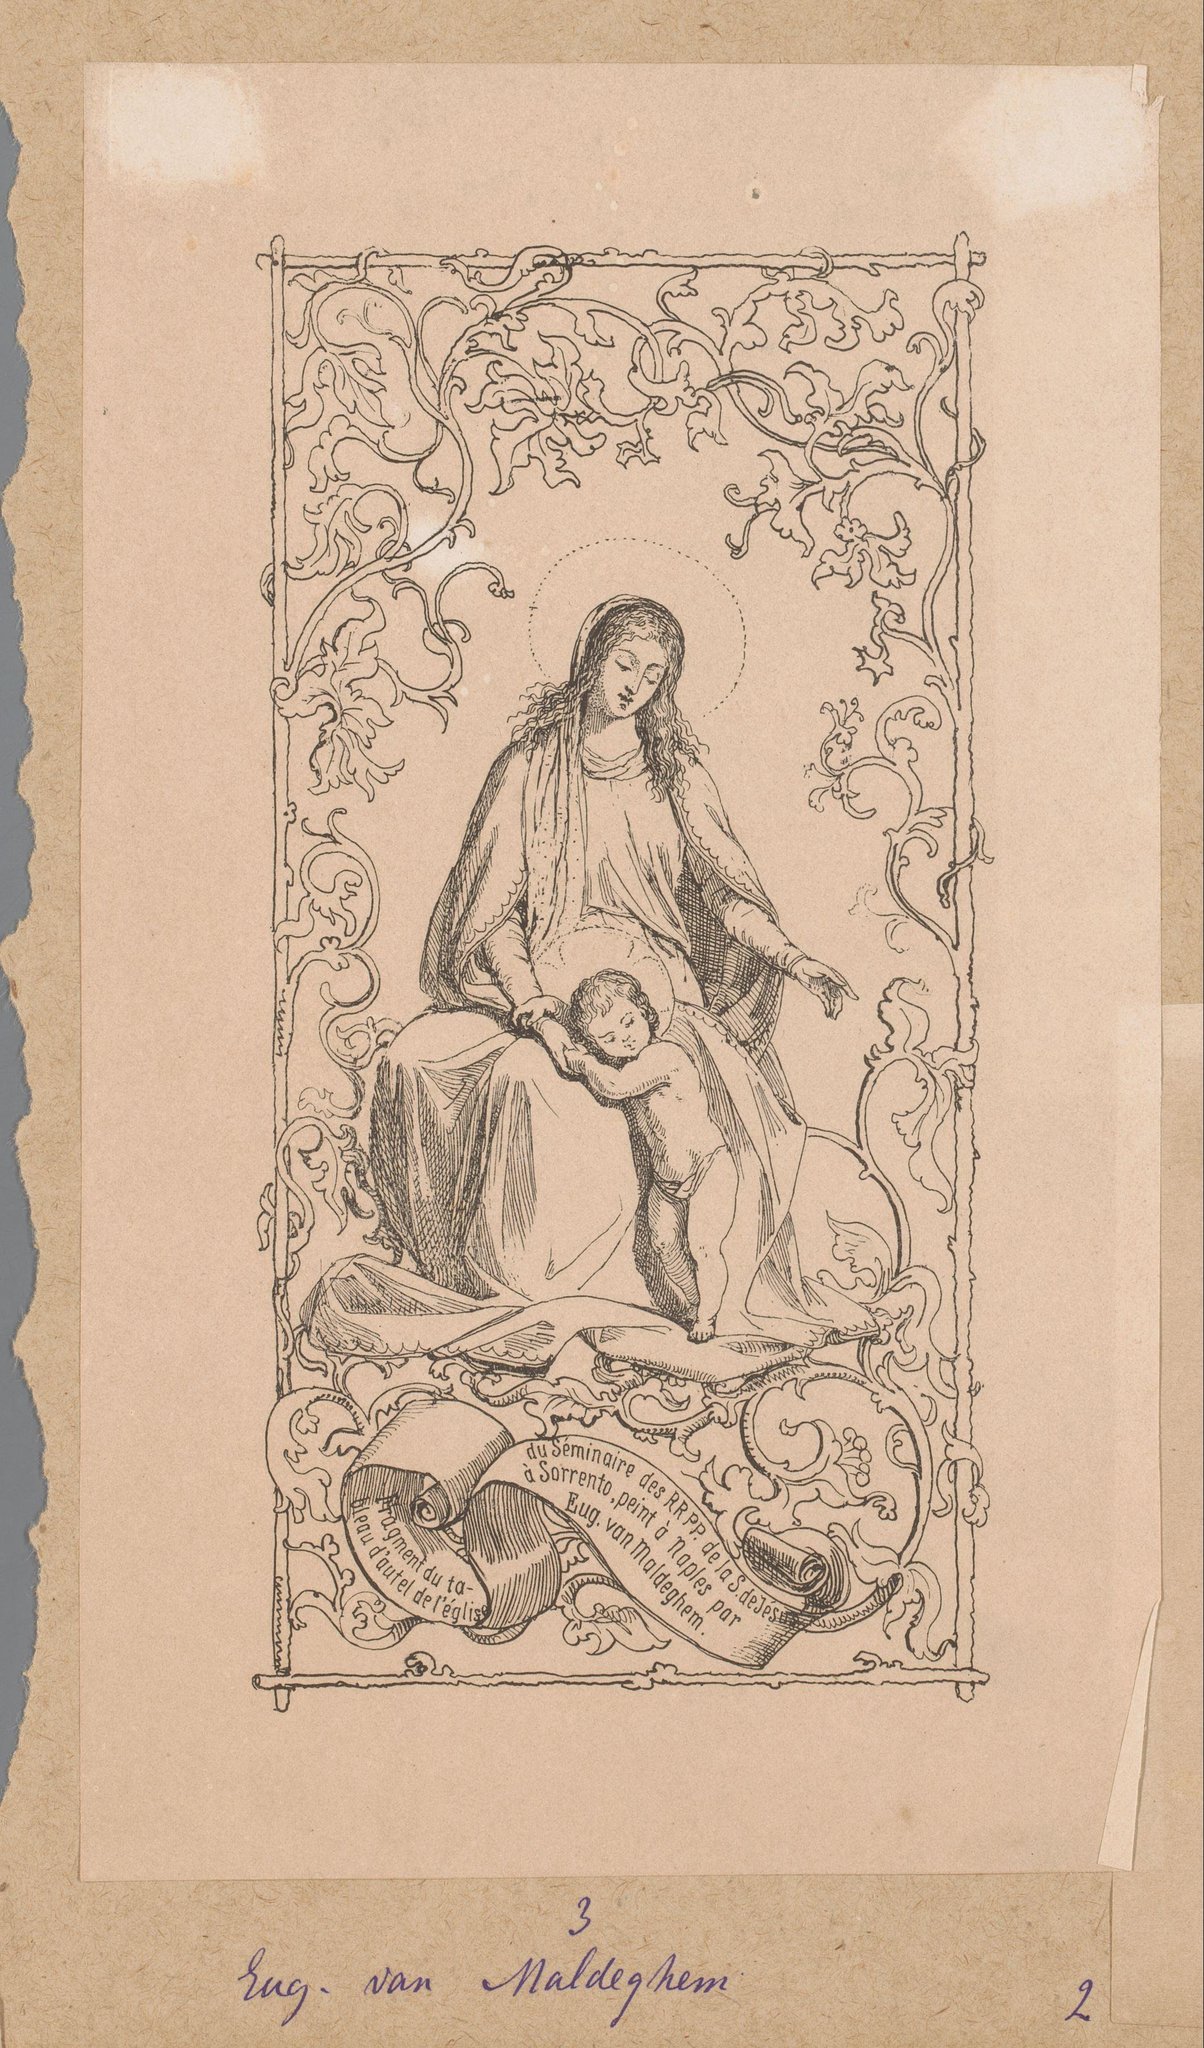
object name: print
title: Fragment du tableau d'autel de l'église (...) Naples par Eug. van Maldeghem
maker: eugène van maldeghem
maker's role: draughtsman, painter, print maker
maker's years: 1813-1867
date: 1823-1867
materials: paper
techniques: etching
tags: floral interlace ~ ornament, madonna: i.e. mary with the christ-child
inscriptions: collector's mark: Lugt 2228, collector's mark: Lugt 1485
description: Fragment uit het altaarstuk in het Seminarium de la Société de Jésus à Sorrento, geschilderd door Eugène van Maldeghem.